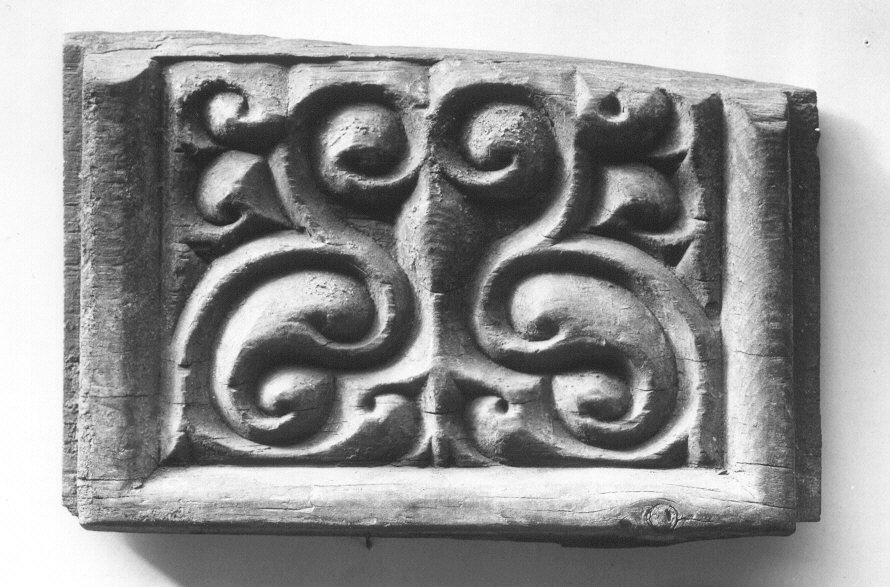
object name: panel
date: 801-1000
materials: wood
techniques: carving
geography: egypt